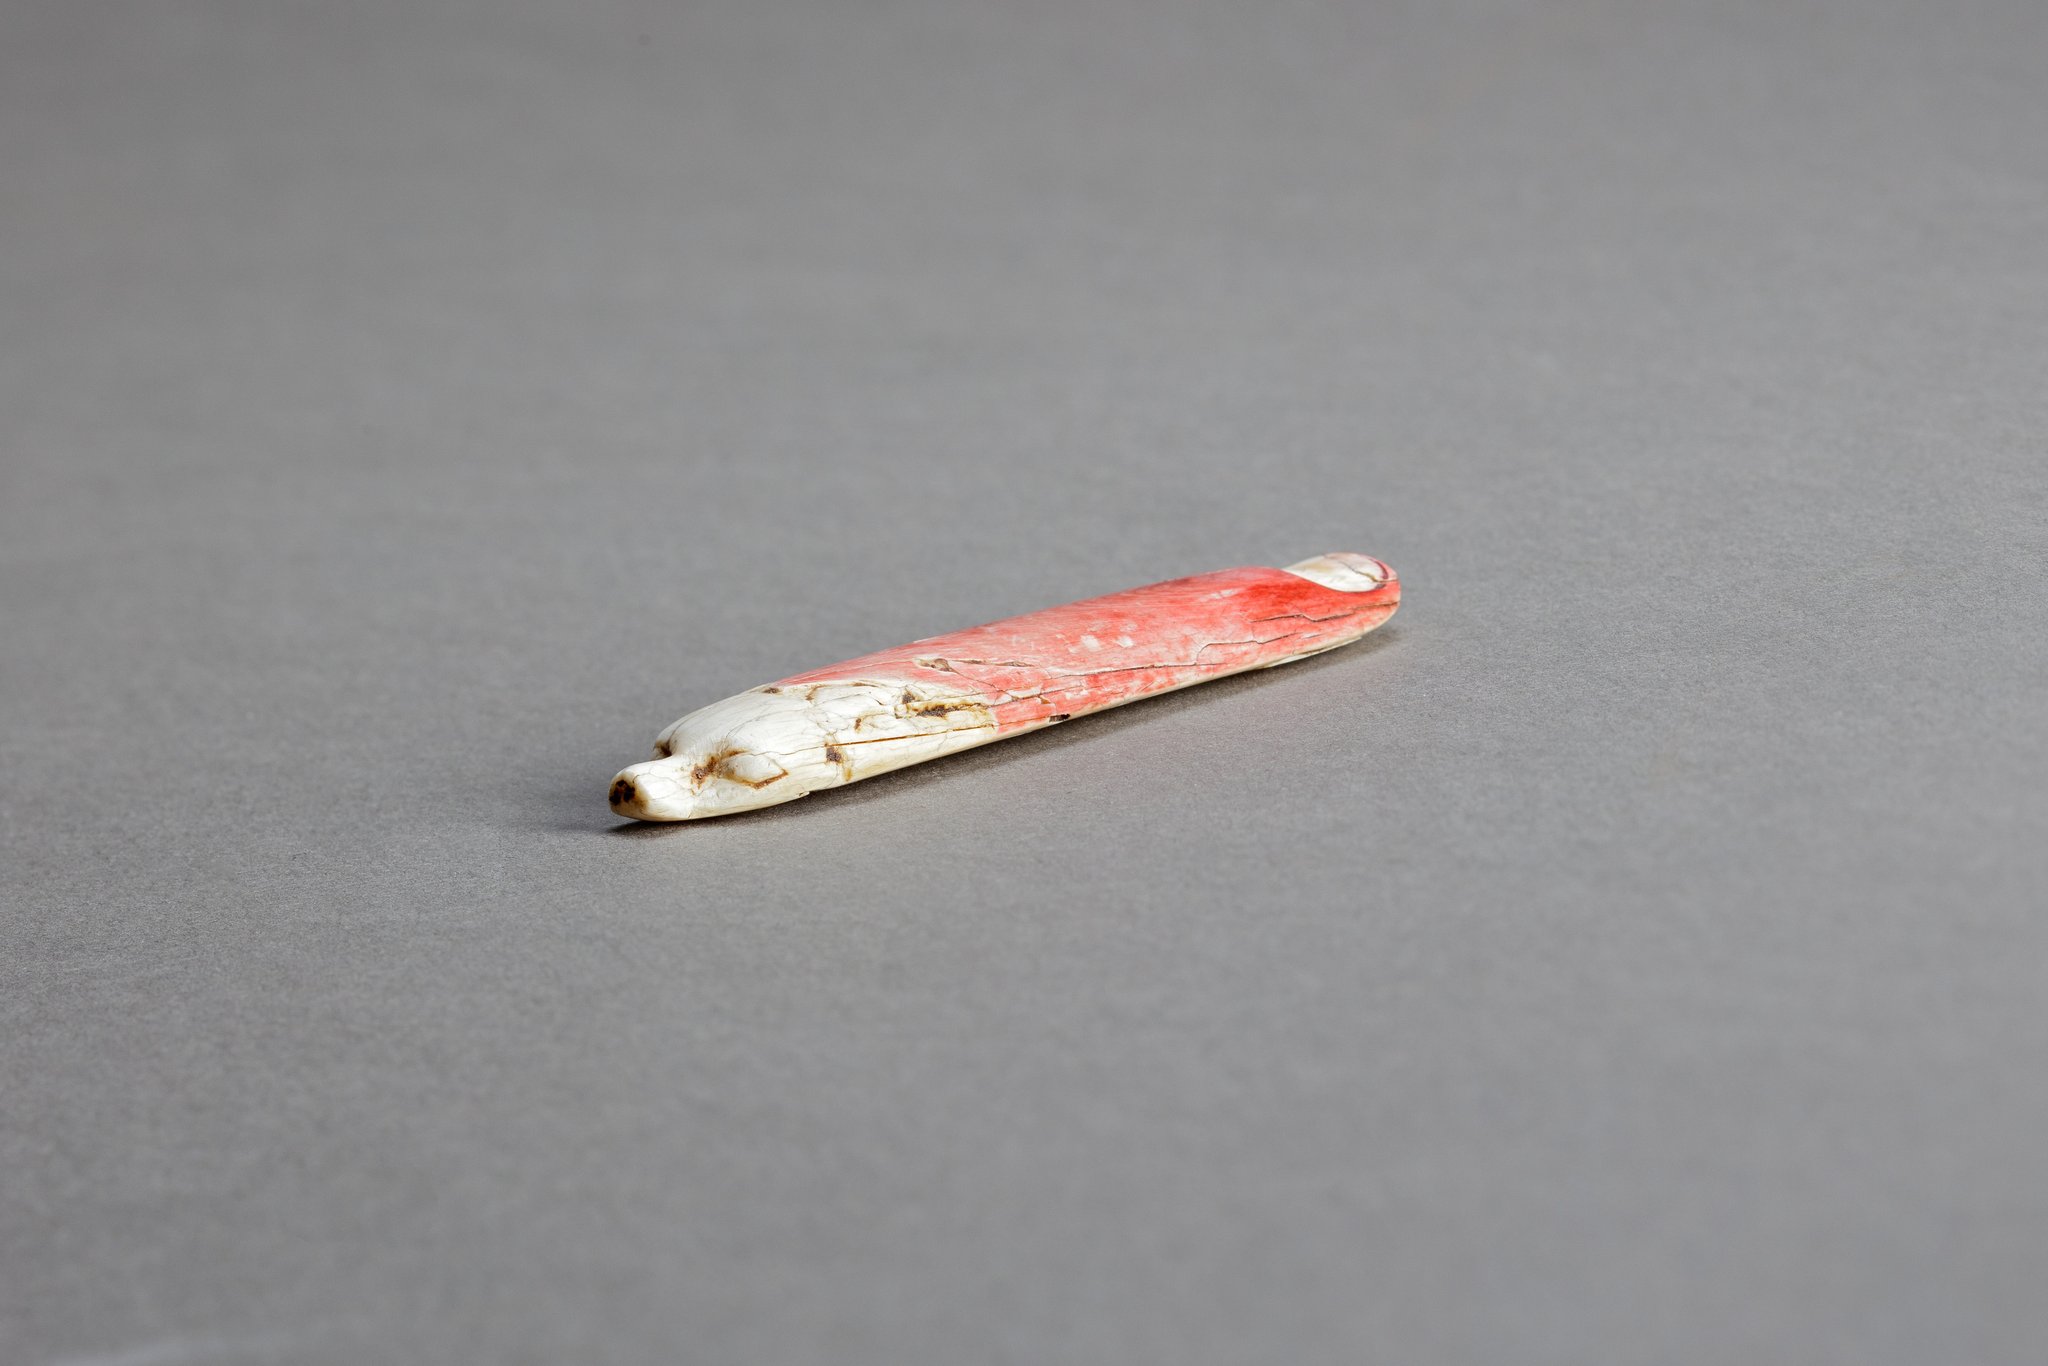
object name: game throw stick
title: Throw Stick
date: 1400-1295 BCE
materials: ivory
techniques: tinting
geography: upper egypt, thebes